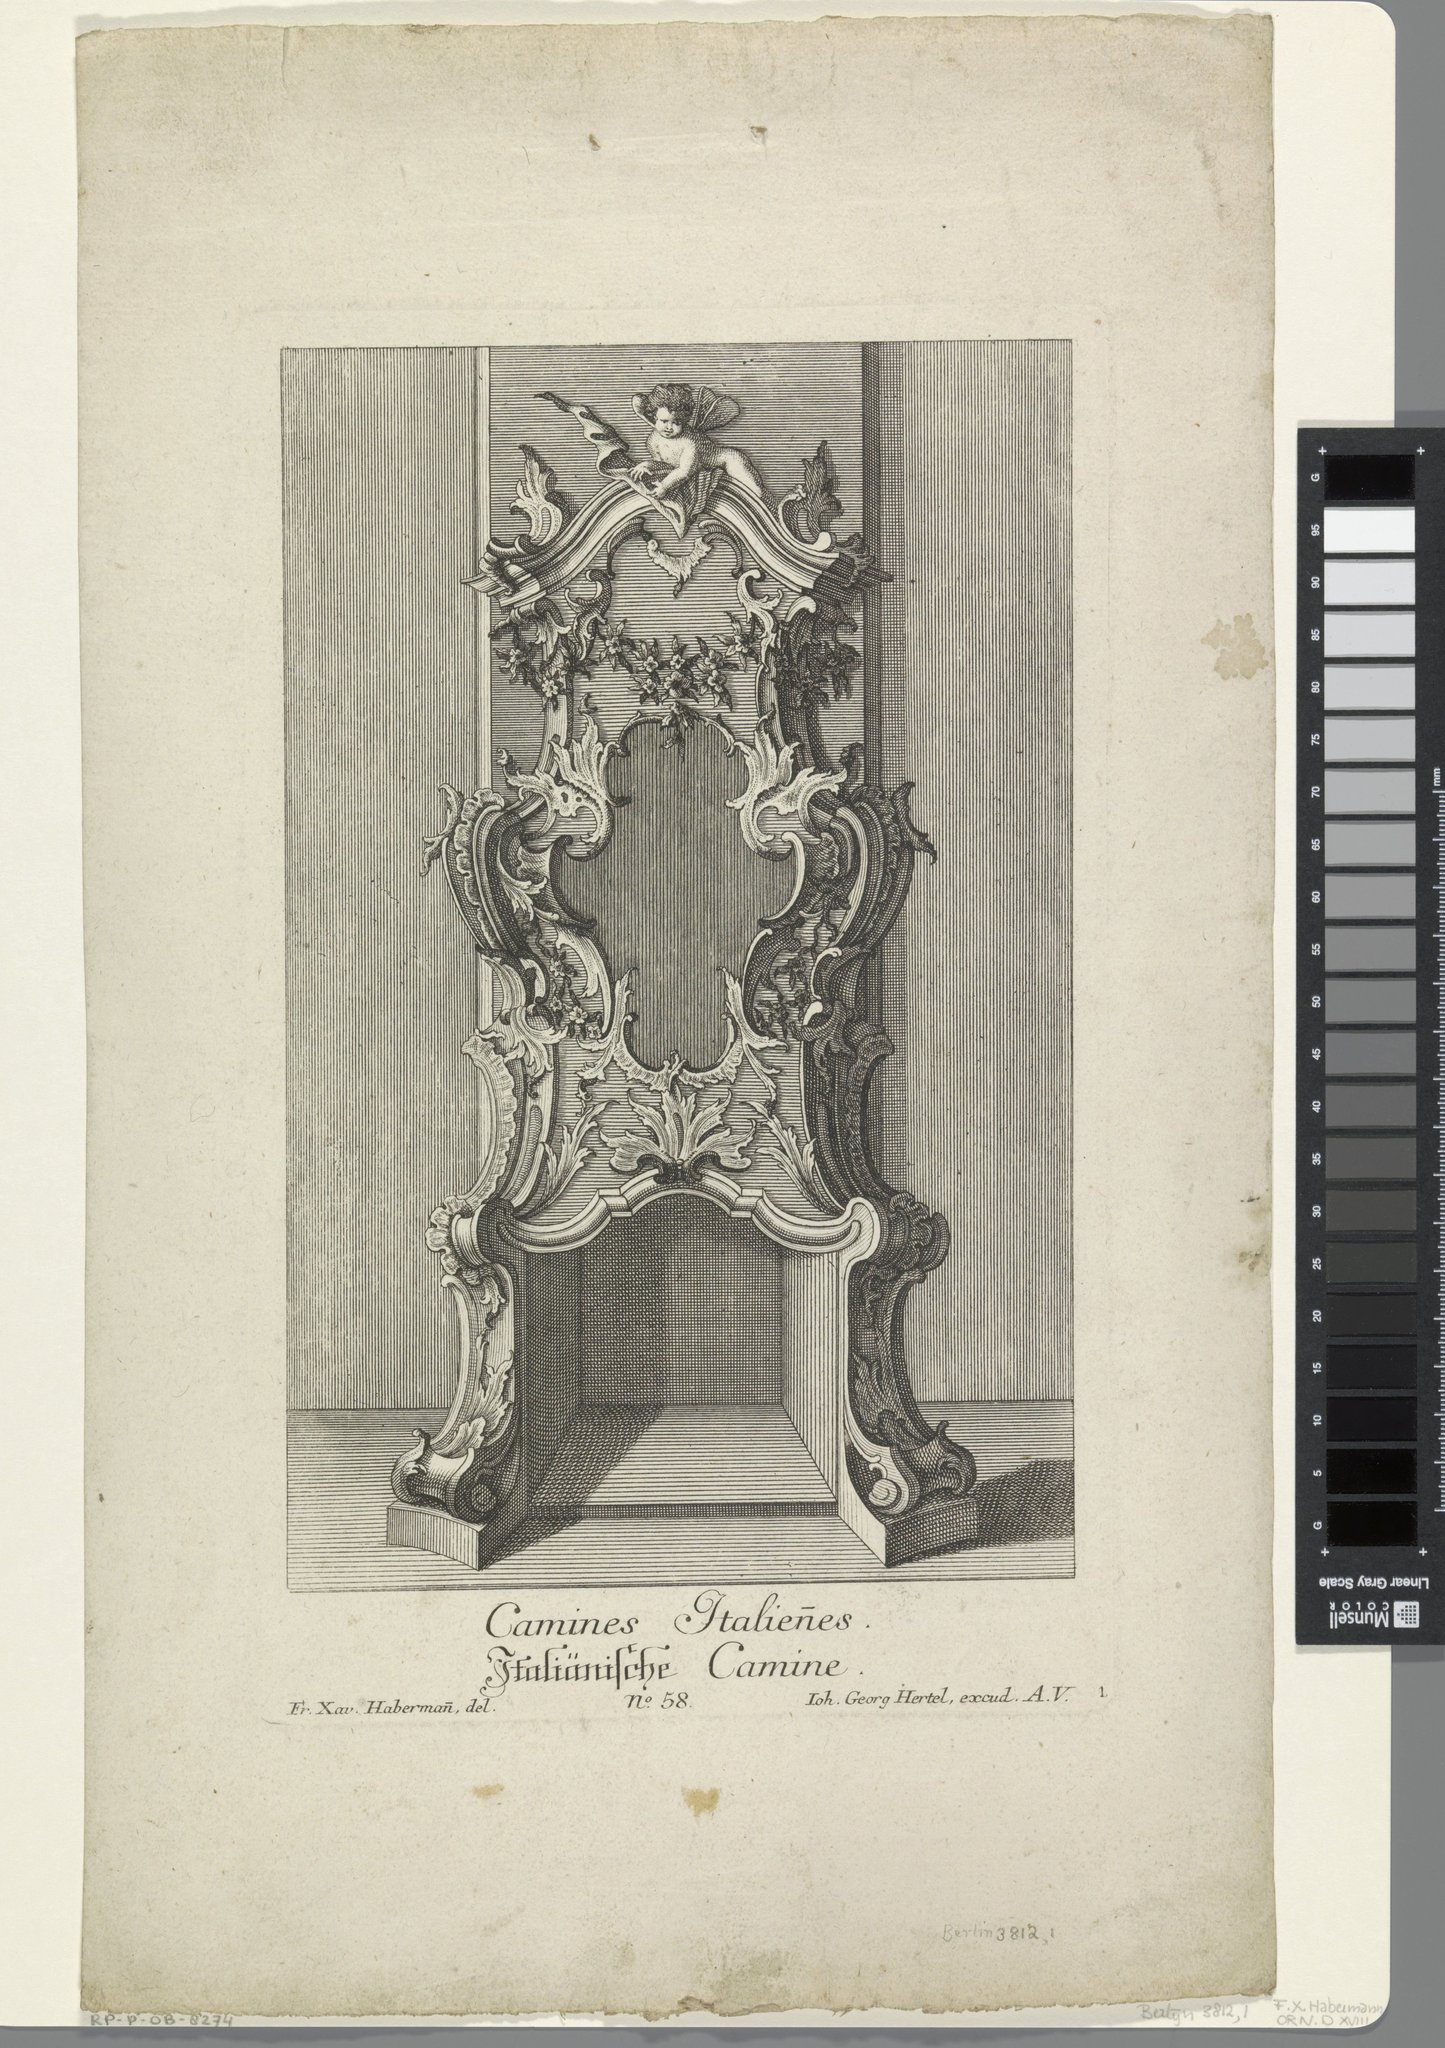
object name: print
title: Schouw met putto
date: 1731-1775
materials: paper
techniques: engraving, etching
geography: augsburg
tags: rocaille ornament, open hearth, fire-place, cupids: 'amores', 'amoretti', 'putti'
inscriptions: collector's mark: Lugt 2228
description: Rocaille schouw met gevleugelde putto. Uitgeversnummer 58.